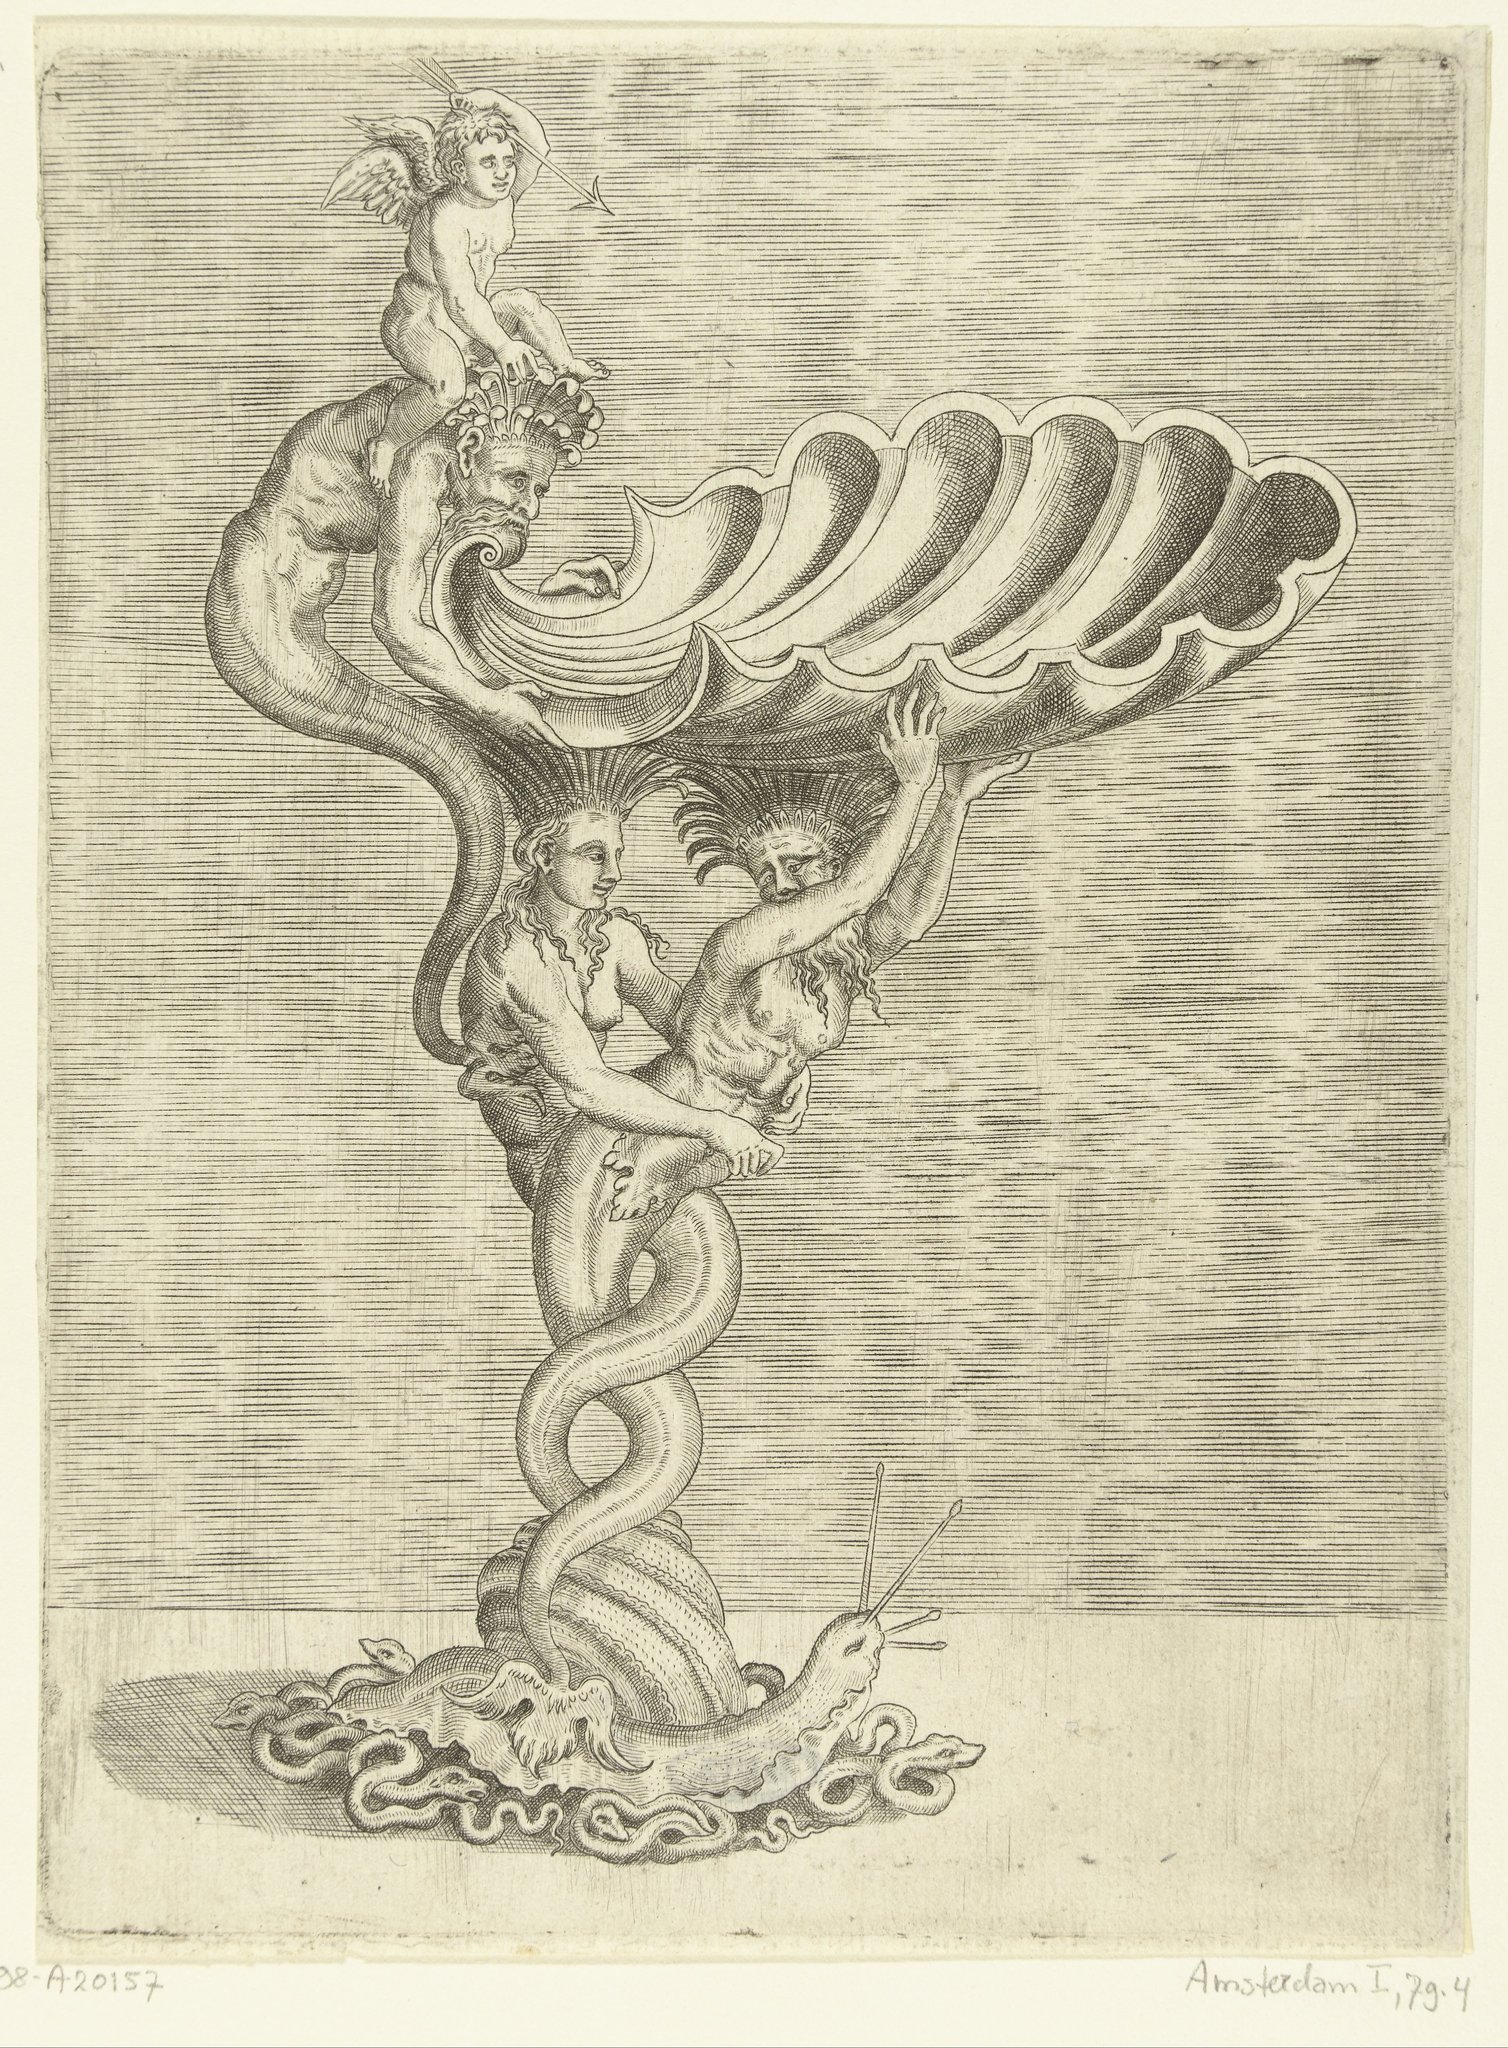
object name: ornament print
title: Vazen, kannen en schalen met grotesken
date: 1548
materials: paper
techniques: engraving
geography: netherlands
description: De zeemeermin en de zeemeerman staan met verstrengelde staarten op een slakkenhuis. Op de schouders van een tweede zeemeerman die de schelp ondersteunt, zit Amor. Afkomstig uit een serie bestaande uit een titelblad en 20 bladen.